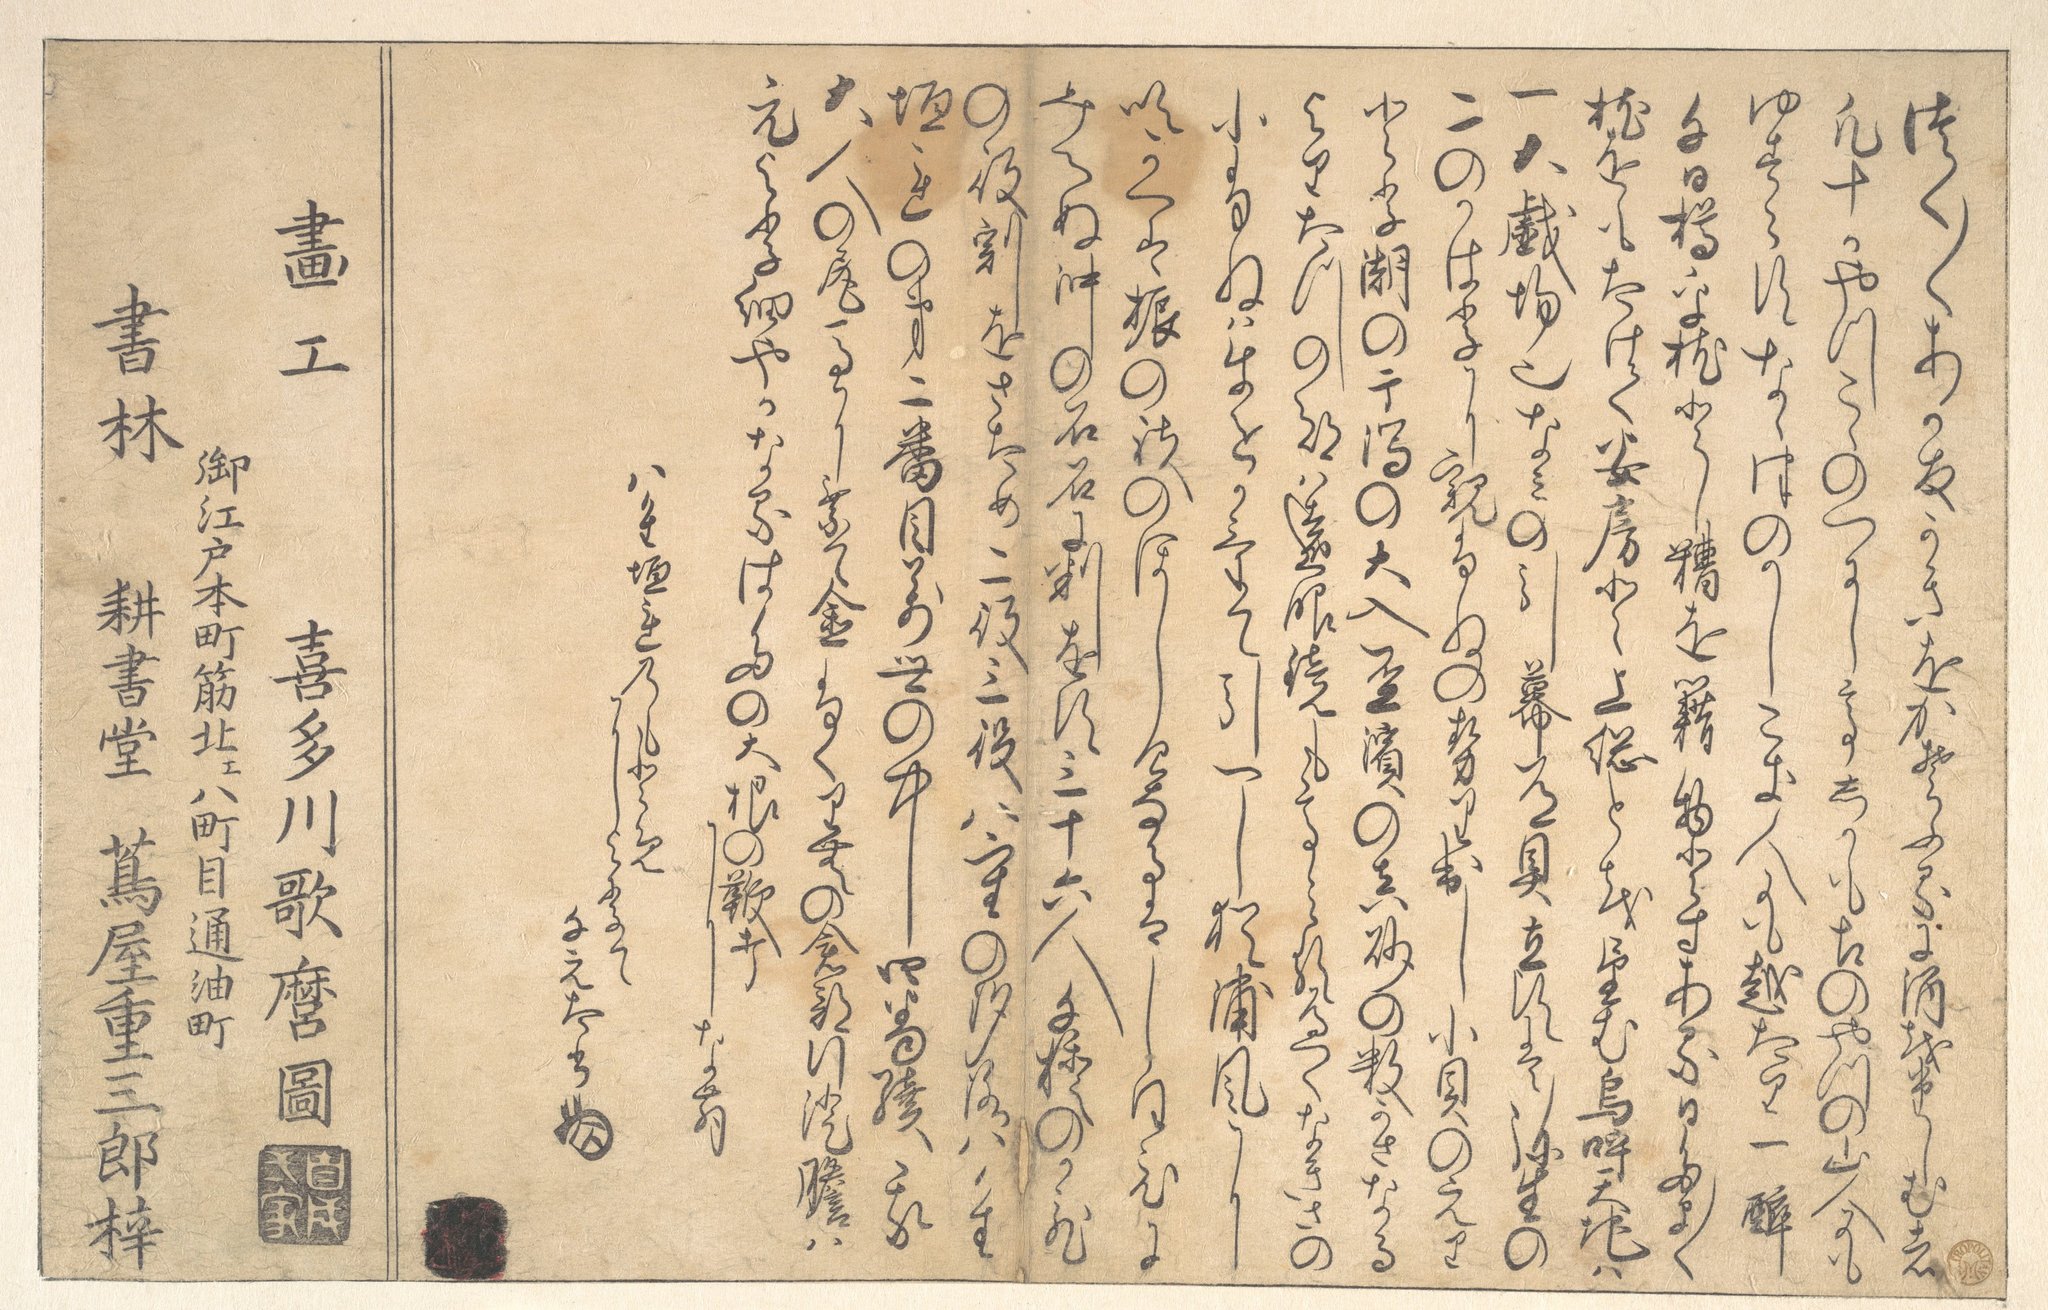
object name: woodblock print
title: Last page of the Book of Shells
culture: japanese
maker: kitagawa utamaro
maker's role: artist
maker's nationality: japanese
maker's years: 1754-1806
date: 1790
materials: ink, paper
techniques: woodblock print